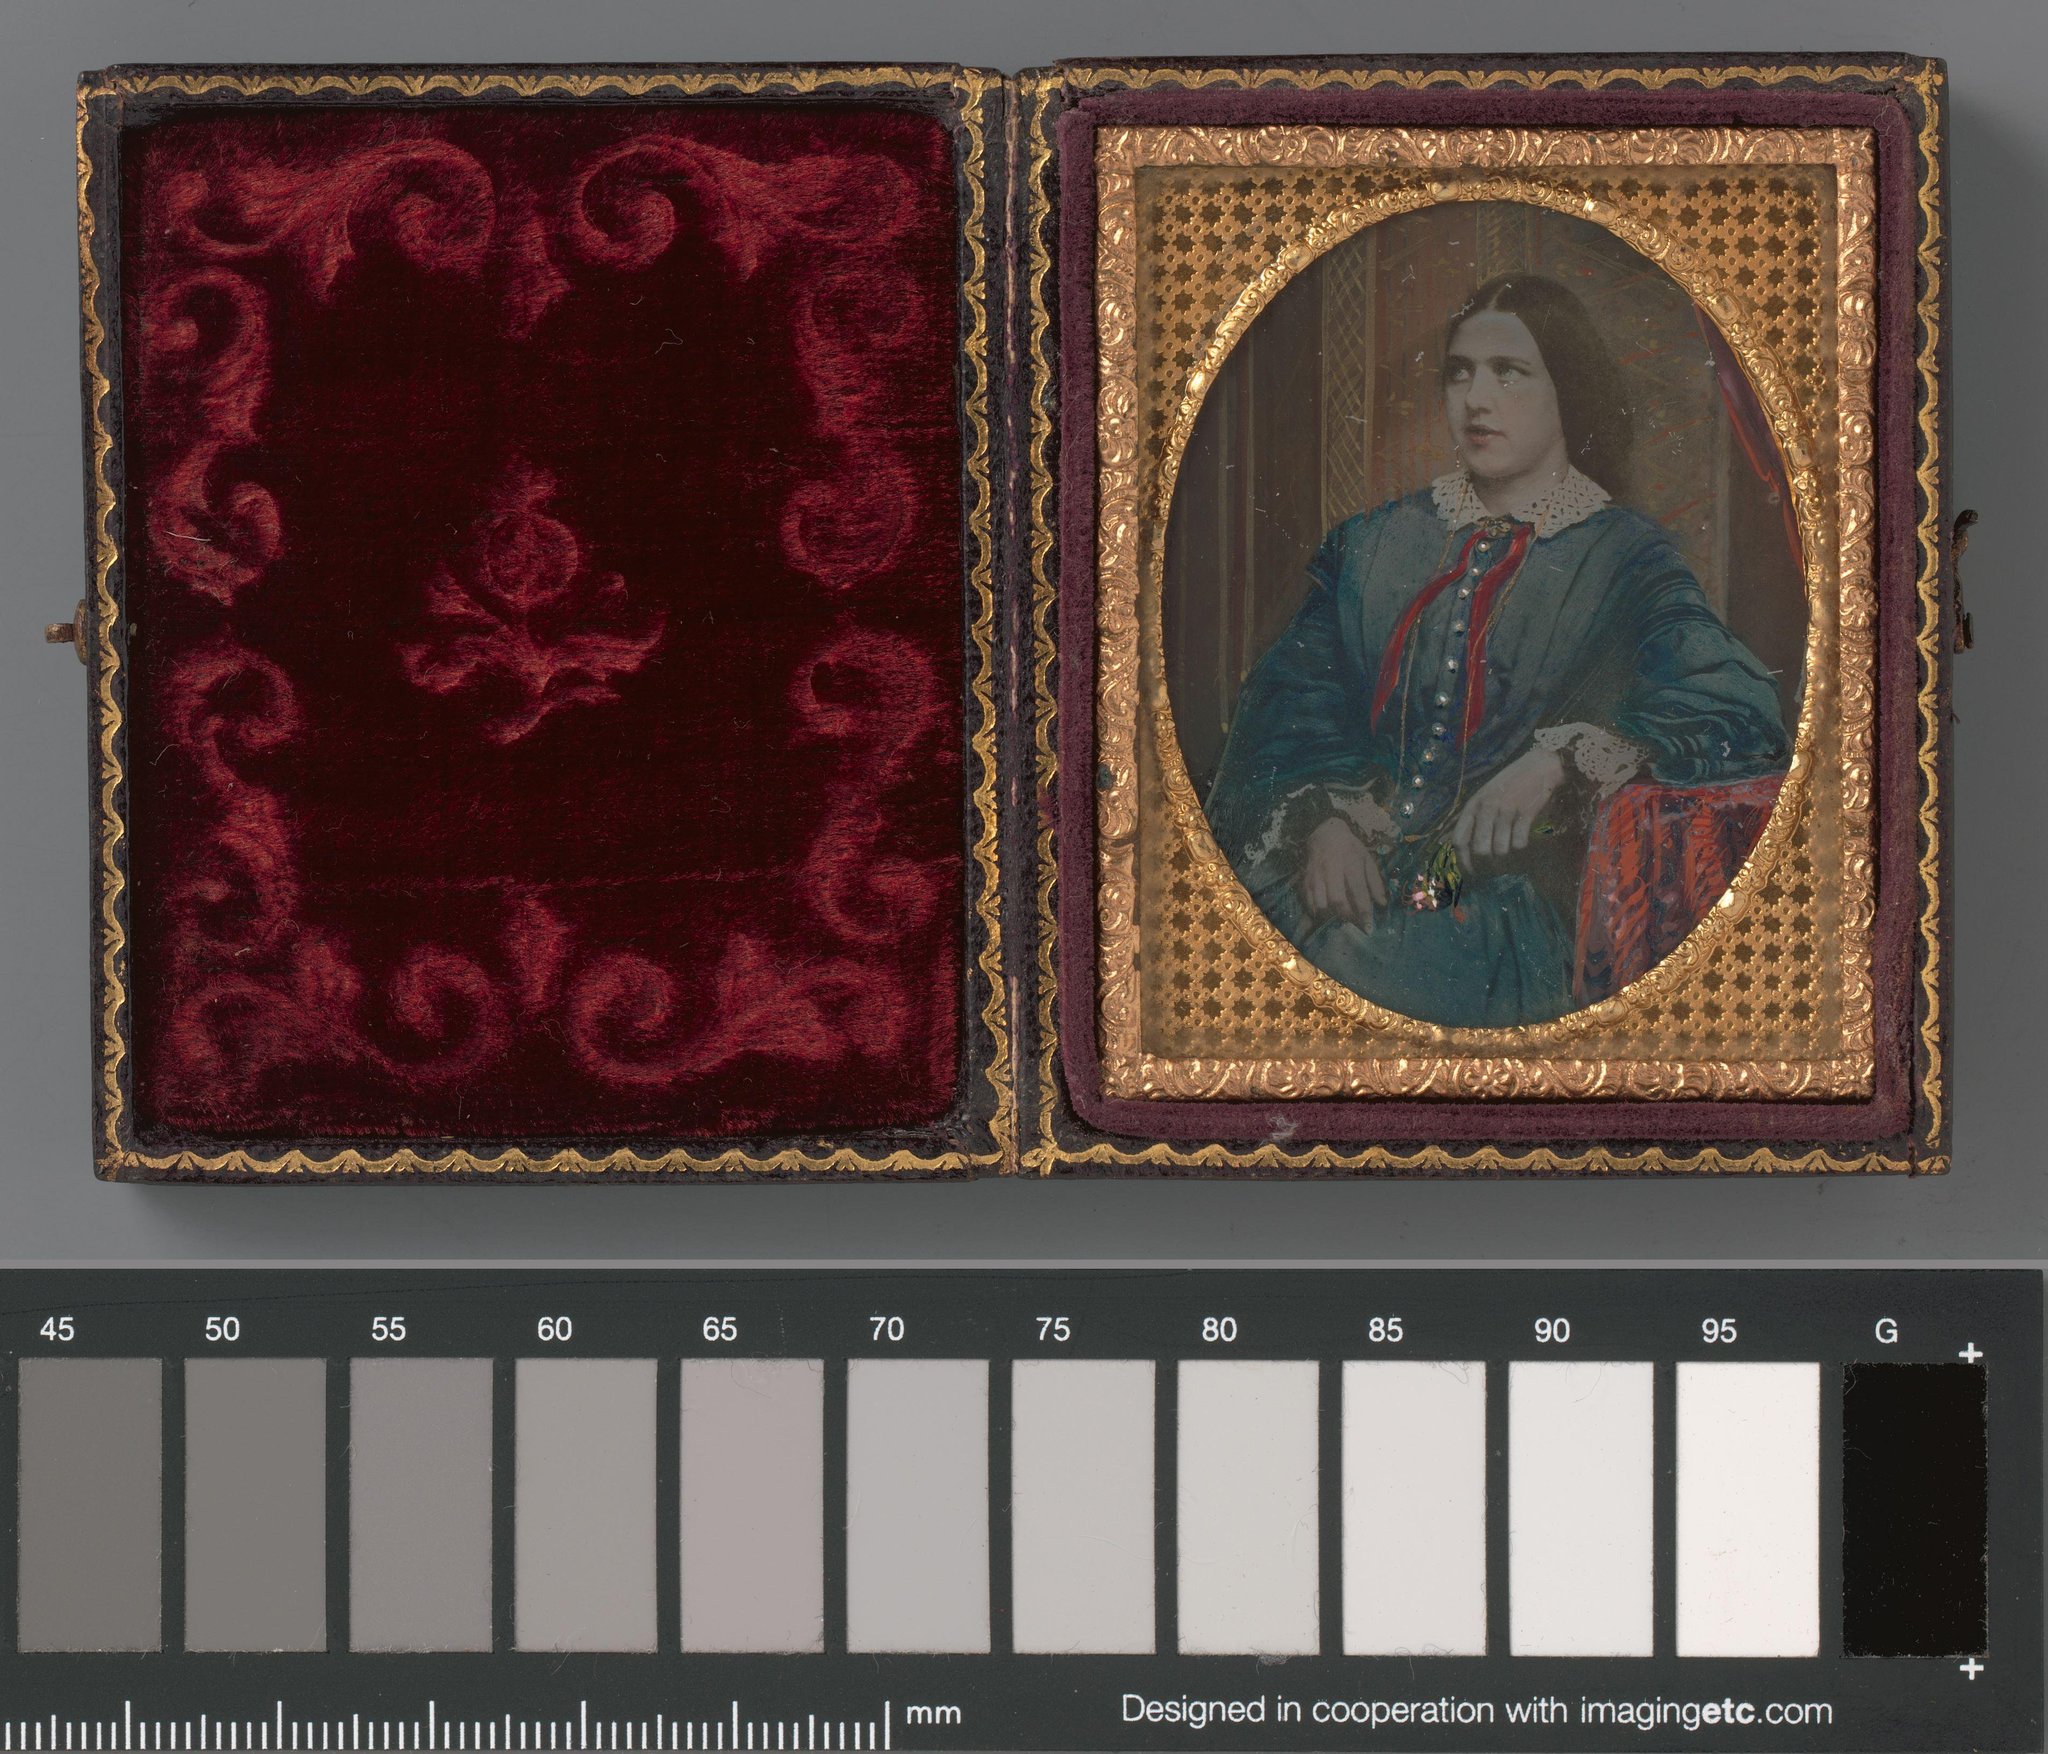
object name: photograph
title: Portret van een onbekende jonge vrouw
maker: Anonymous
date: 1855-1870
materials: glass, metal, velvet, wood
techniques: ambrotype, hand coloring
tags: adolescent, young woman, maiden, sitting figure - aa - female human figure, historical persons - bb - woman